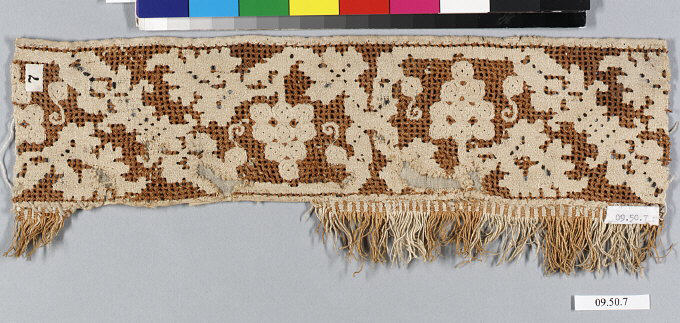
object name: strip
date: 1501-1700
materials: linen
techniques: embroidery